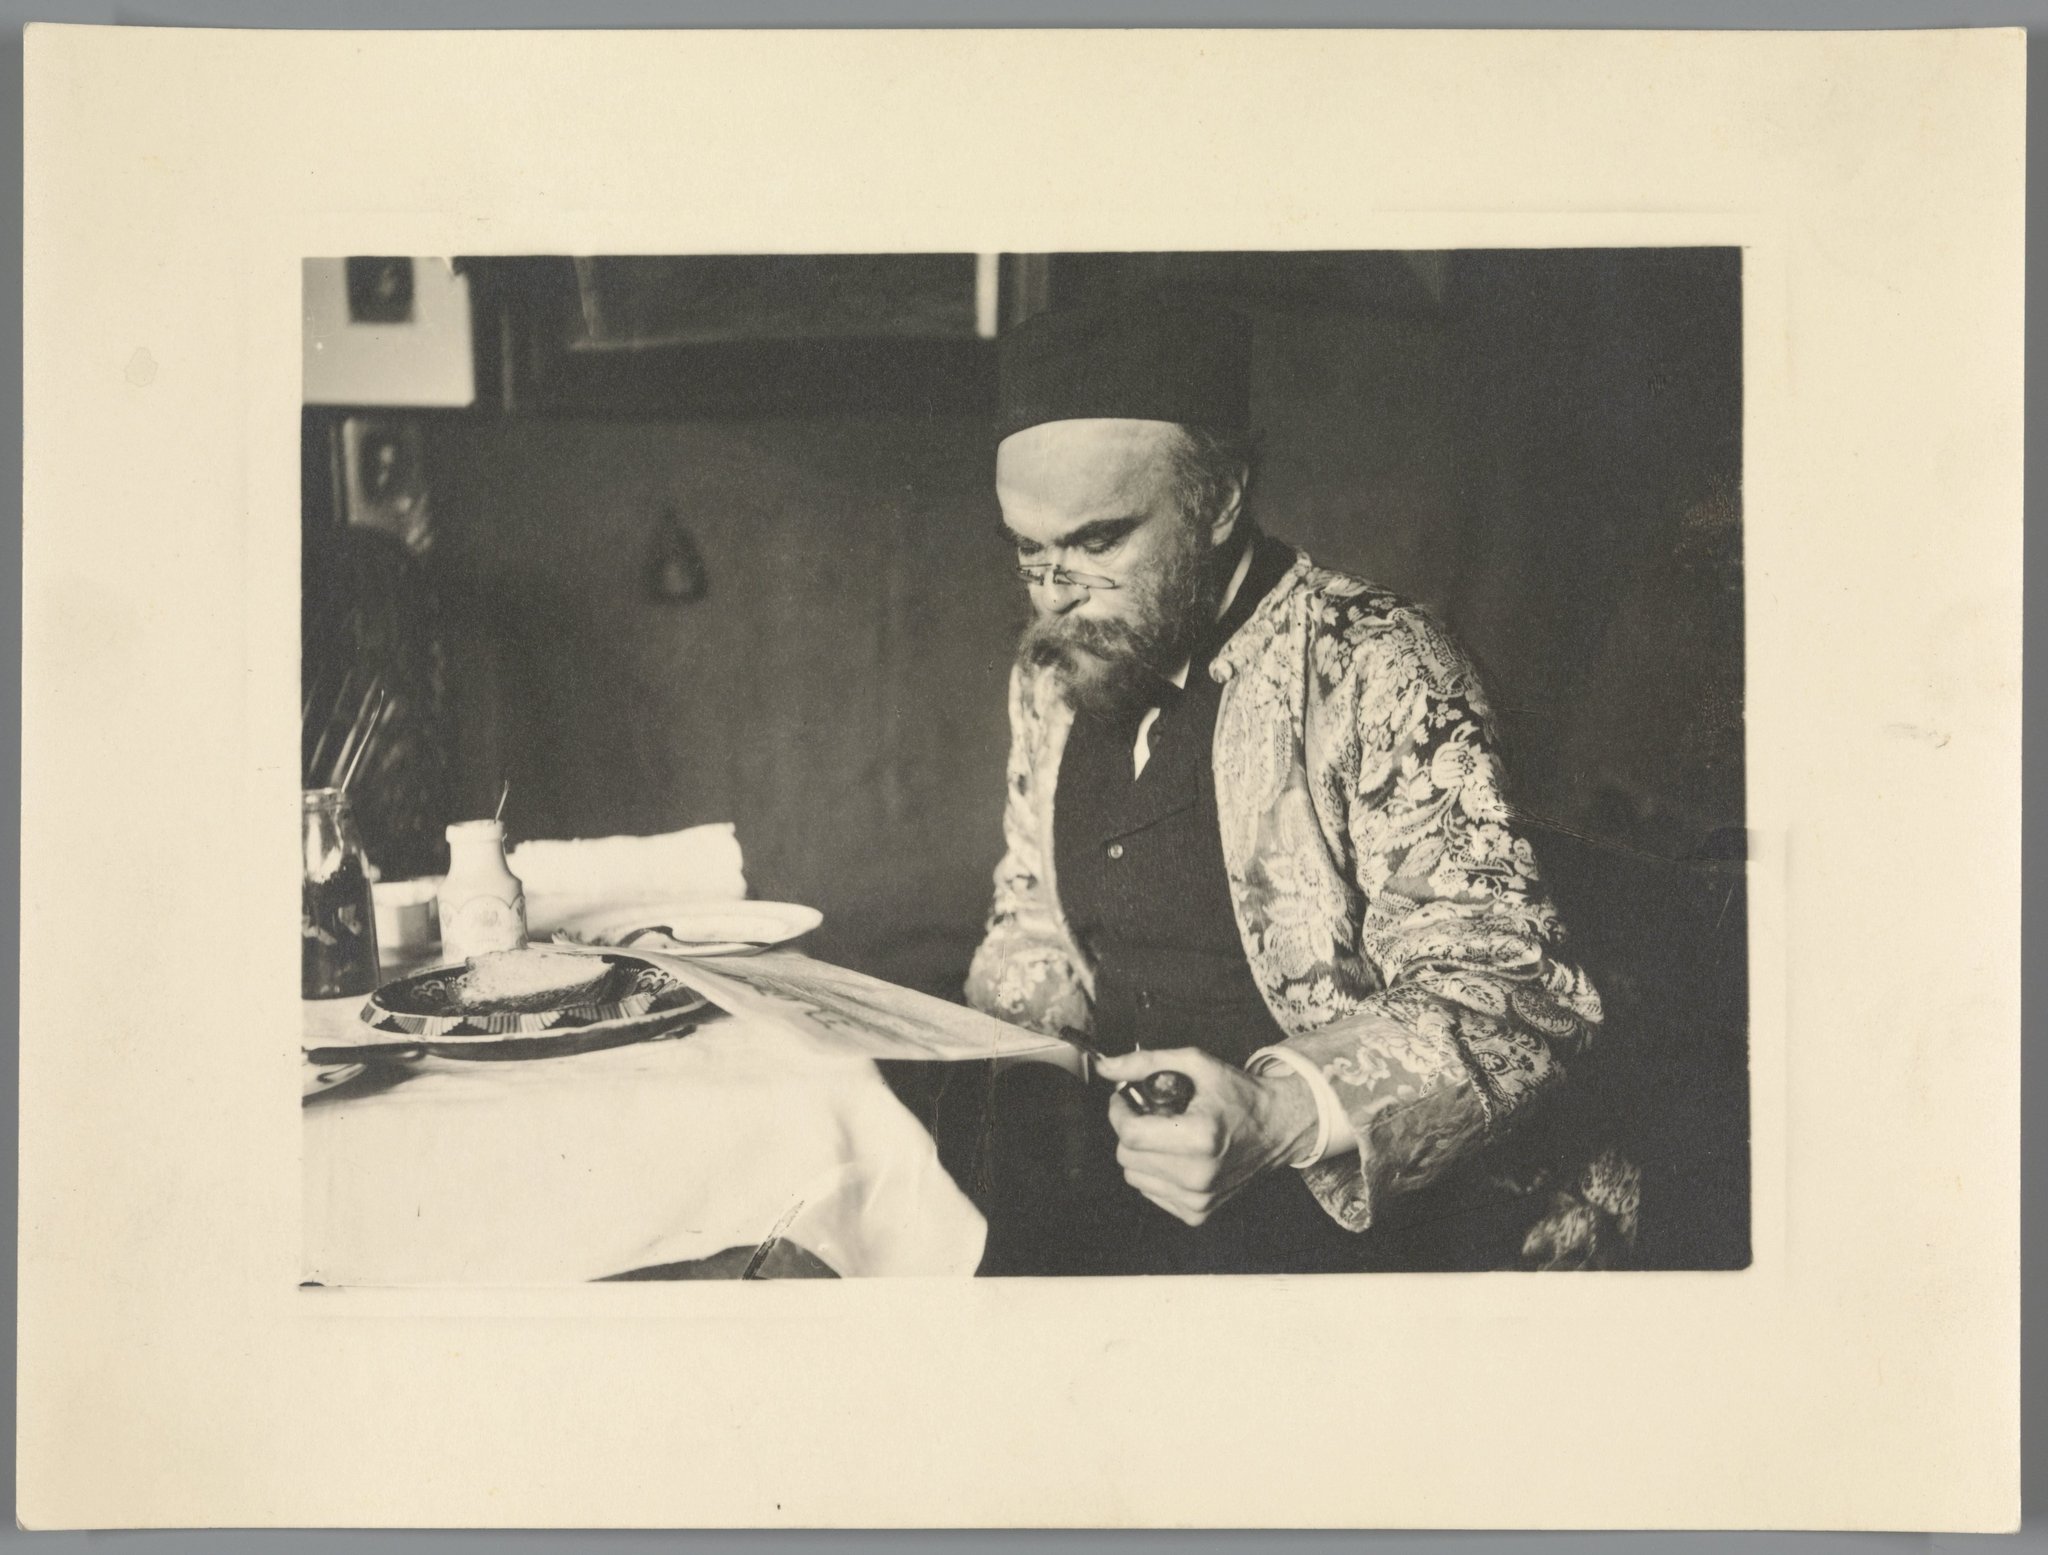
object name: photograph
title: Reproductie naar een foto van Willem Witsen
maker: Anonymous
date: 1860-1915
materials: paper, photographic support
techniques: gelatin silver print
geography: netherlands